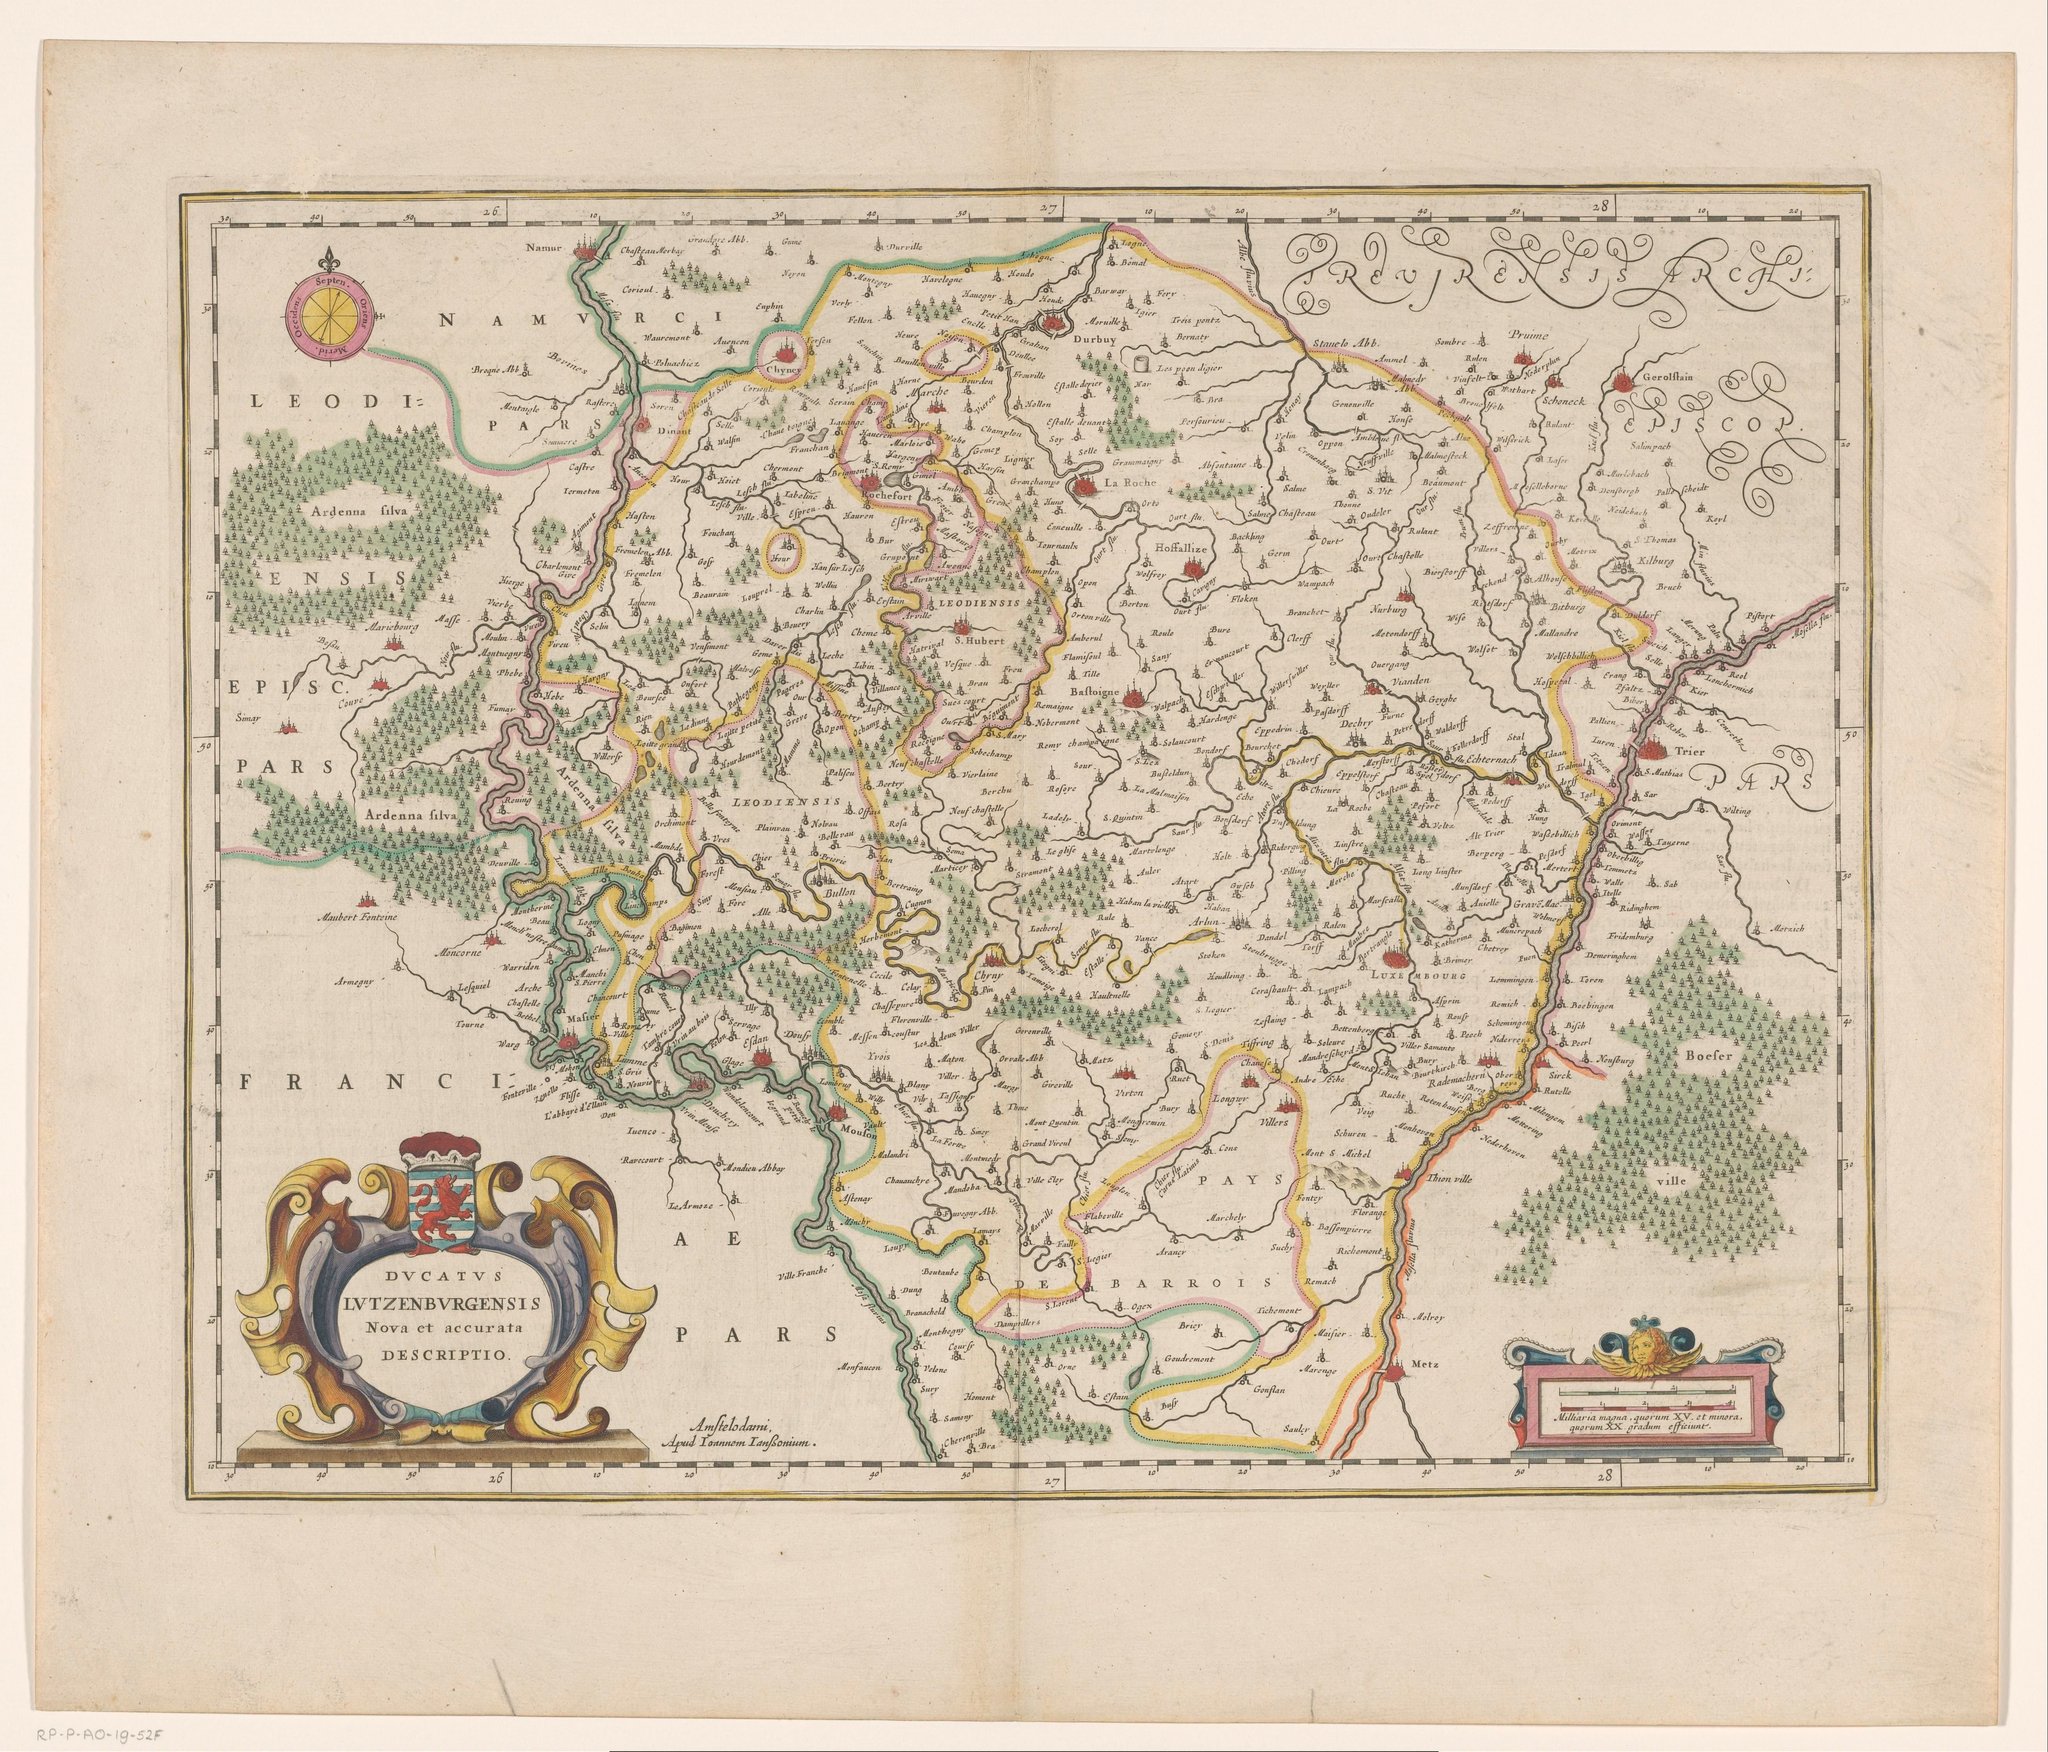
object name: map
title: Ducatus Lutzenburgensis nova et accurata descriptio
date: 1666-1680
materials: paper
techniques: engraving, hand coloring, letterpress printing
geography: amsterdam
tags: maps of separate countries or regions, coat of arms (as symbol of the state, etc.) (+ province; provincial)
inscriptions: collector's mark: Lugt 2228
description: Prent gebruikt in: Janssonius, Johannes. Atlas Contractus, sive Atlantis Majoris Compendium (…). 2 delen. Amsterdam: erven Johannes Janssonius, 1666, dl. 1. Of in: Janssonius, Johannes. Atlas Major, sive Cosmographia Universalis (…). Amsterdam: erven Johannes Janssonius, 1675, dl. 3. Of in: Novus Atlas, sive Theatrum Orbis Terrarum: Tabulae & Descriptiones Omnium Regionum Totius Universi Accuratissime Exhibentur. 5 delen. Amsterdam: Johannes Janssonius van Waesberge (I), s.d. [na ca. 1680], dl. 2.